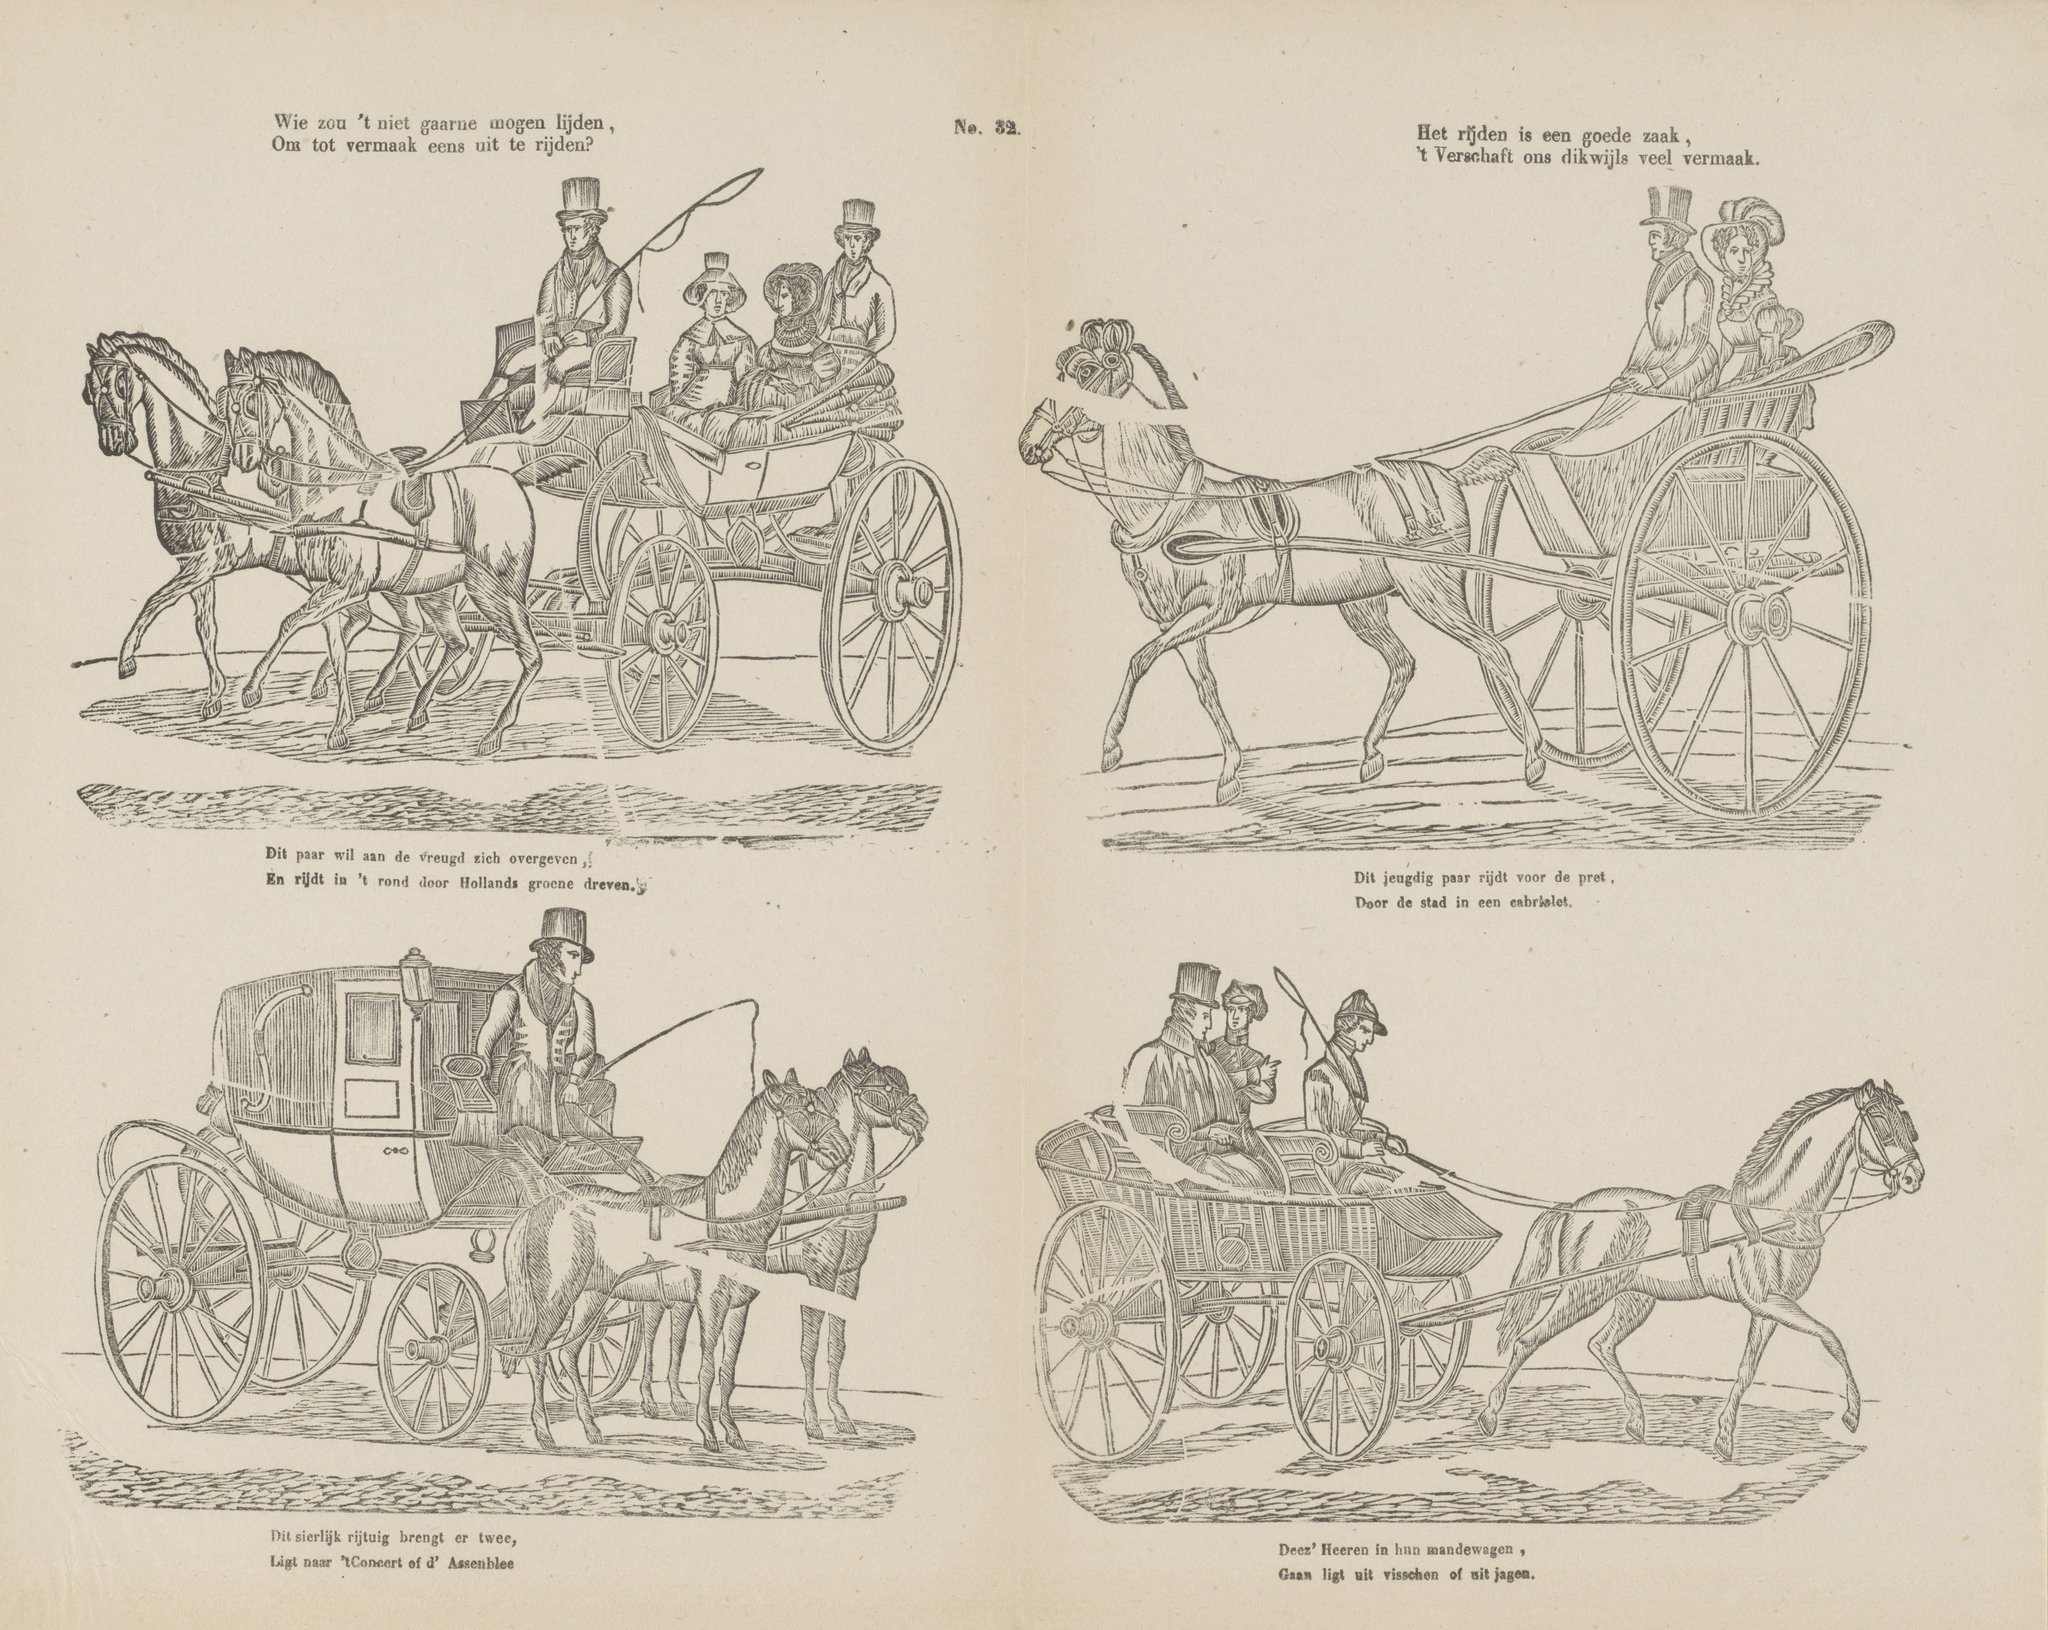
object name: print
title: Wie zou 't niet gaarne mogen lijden, / Om tot vermaak eens uit te rijden? / Het rijden is een goede zaak, / 't verschaft ons dikwijls veel vermaak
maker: Anonymous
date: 1848-1881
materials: paper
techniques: letterpress printing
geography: netherlands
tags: four-wheeled, animal-drawn vehicle, e.g.: cab, carriage, coach, two-wheeled vehicle drawn by one animal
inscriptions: collector's mark: Lugt 2760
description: Blad met 4 voorstellingen van rijtuigen. Onder elke afbeelding een tweeregelig vers. Genummerd midden boven: No. 32.